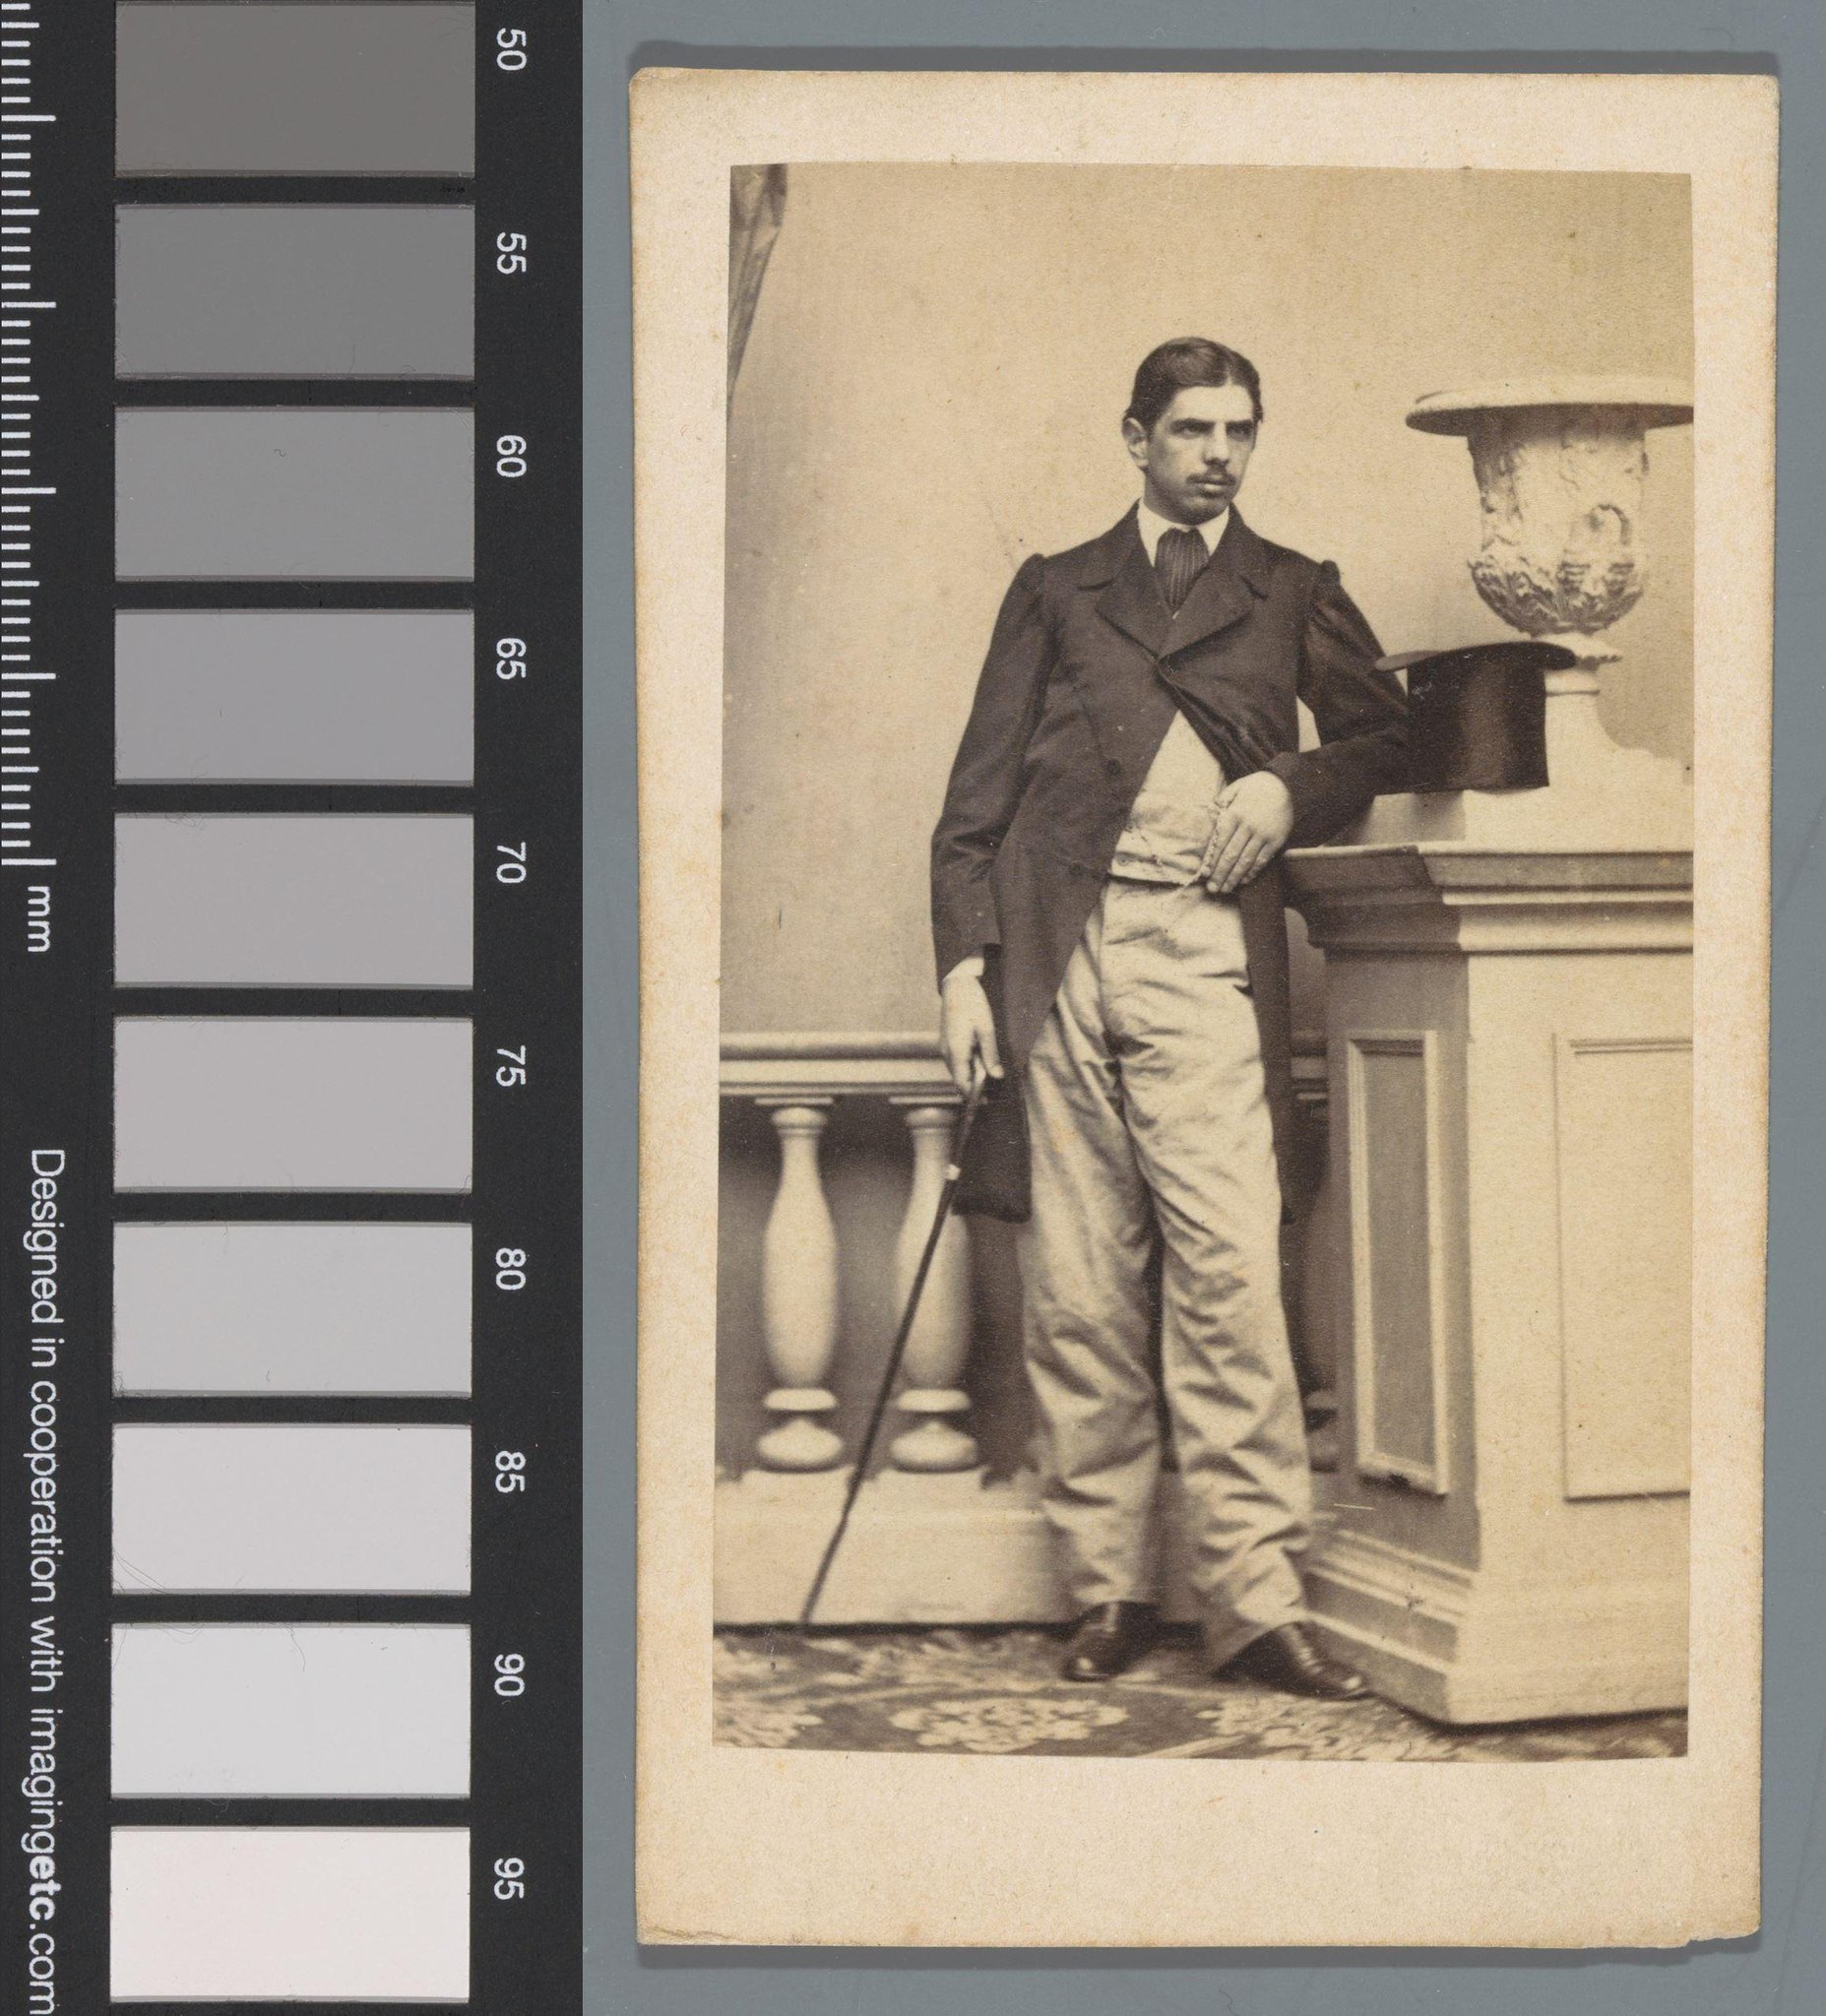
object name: carte de visite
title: Portret van een onbekende man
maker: m. endres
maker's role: fotograaf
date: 1855-1885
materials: cardboard, paper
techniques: albumen print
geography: innsbruck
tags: adult man, anonymous historical person portrayed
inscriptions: inscription: ‘M. Endres/ Photograph/ Innsbruck’